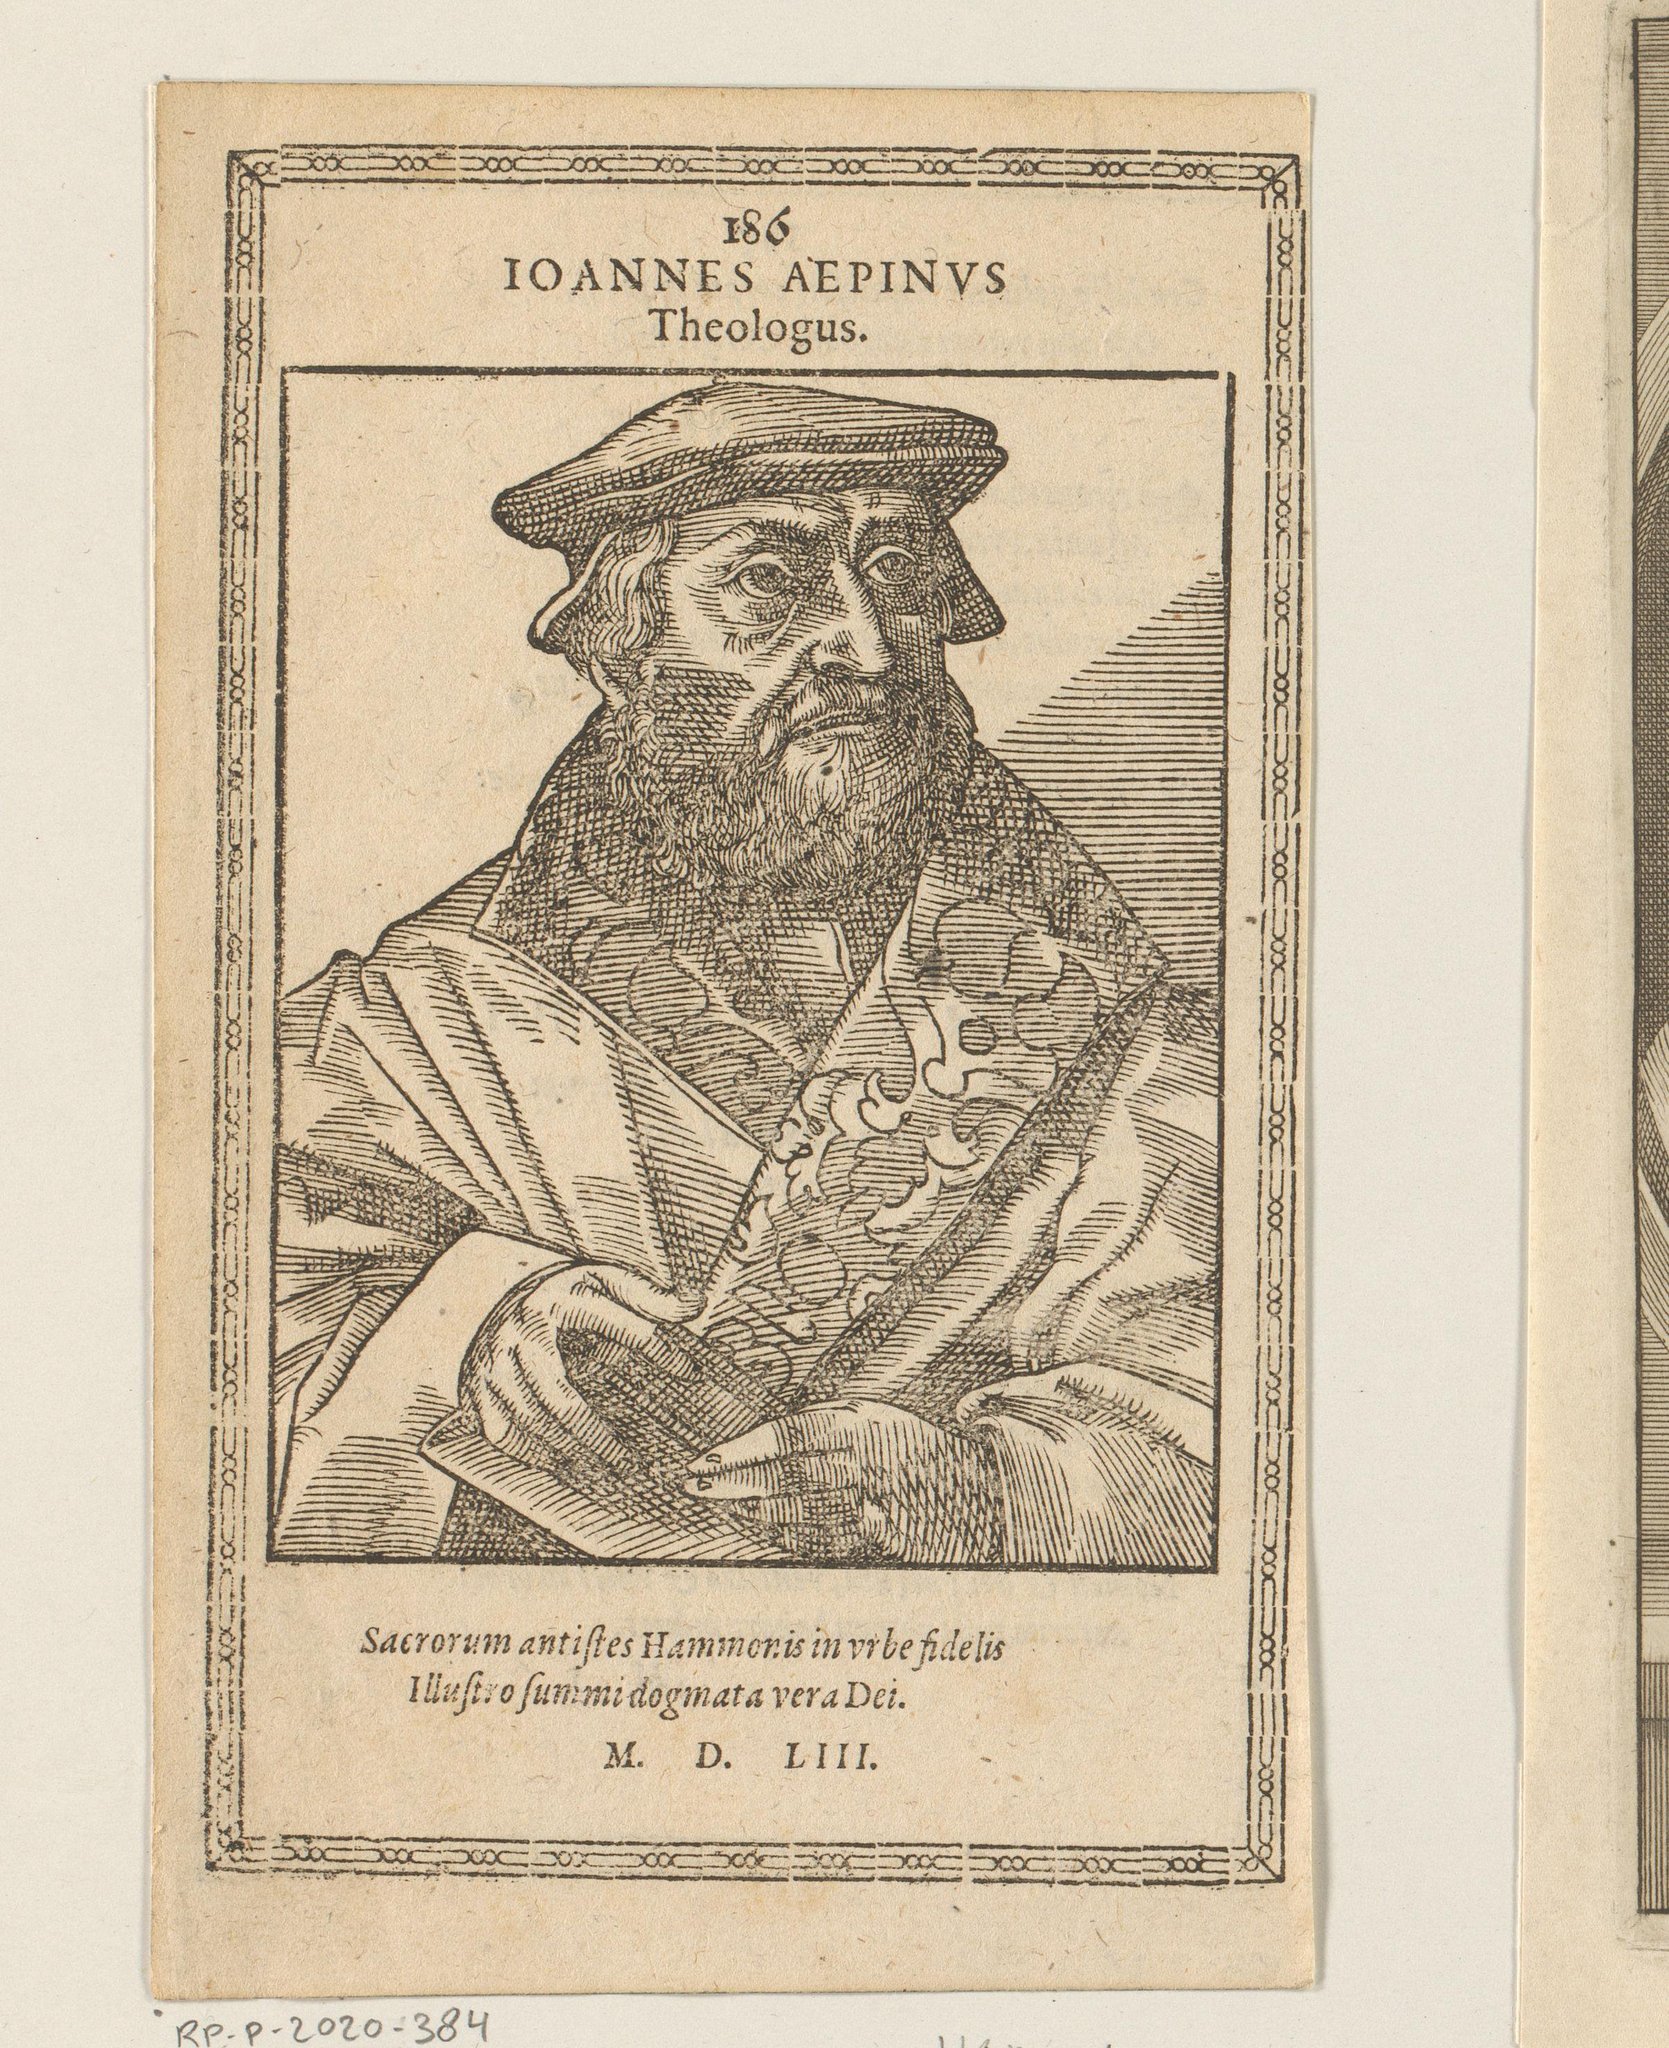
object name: print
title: Portret van Johannes Aepinus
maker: bernhard jobin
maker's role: printer, publisher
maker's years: 1545-1593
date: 1590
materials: paper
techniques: letterpress printing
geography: straatsburg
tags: theologian, historical persons, book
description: Prent uit: Reusner, Nikolaus. Icones sive imagines virorum literis illustrium (...). Straatsburg: Bernhard Jobin, 1590, p. 186. Prent voor het eerst verschenen in de eerste editie van 1587. Prent ook gebruikt in latere publicaties.